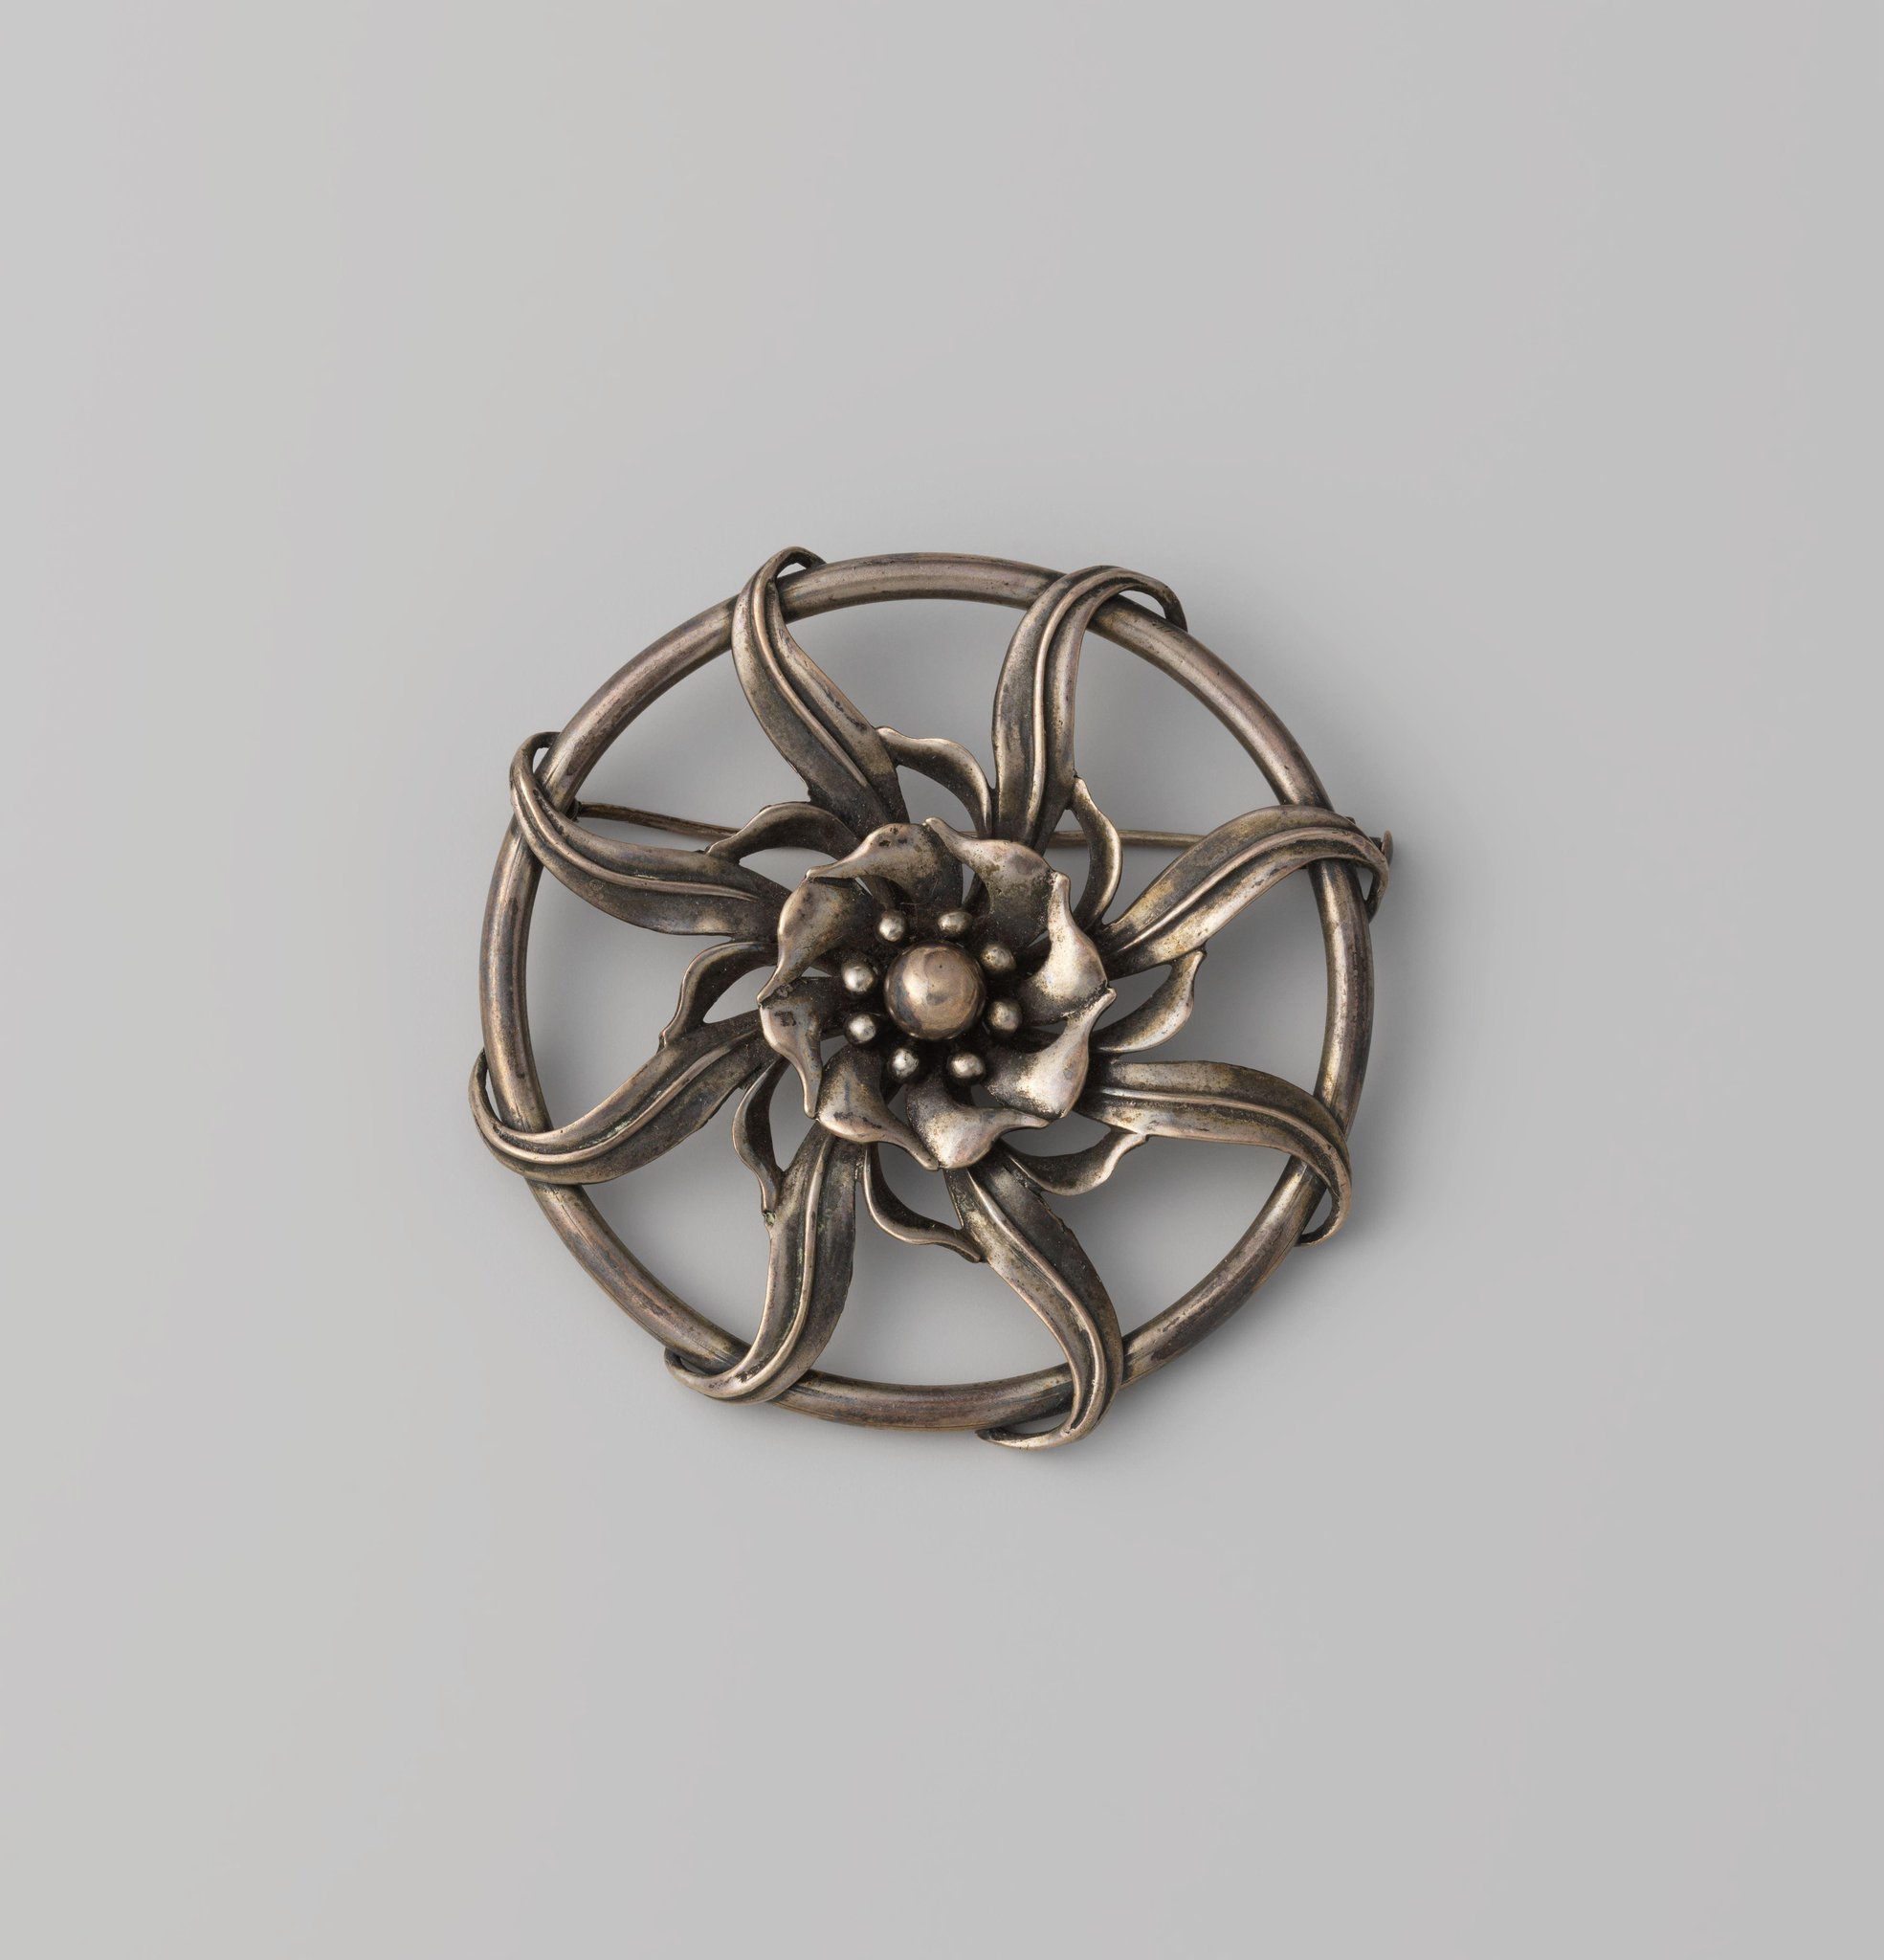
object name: brooch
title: Ronde broche van zilver met bloem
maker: Anonymous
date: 1948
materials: silver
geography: voorschoten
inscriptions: : ‘I’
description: Ronde broche van zilver met bloem voorzien van een kanonsluiting.